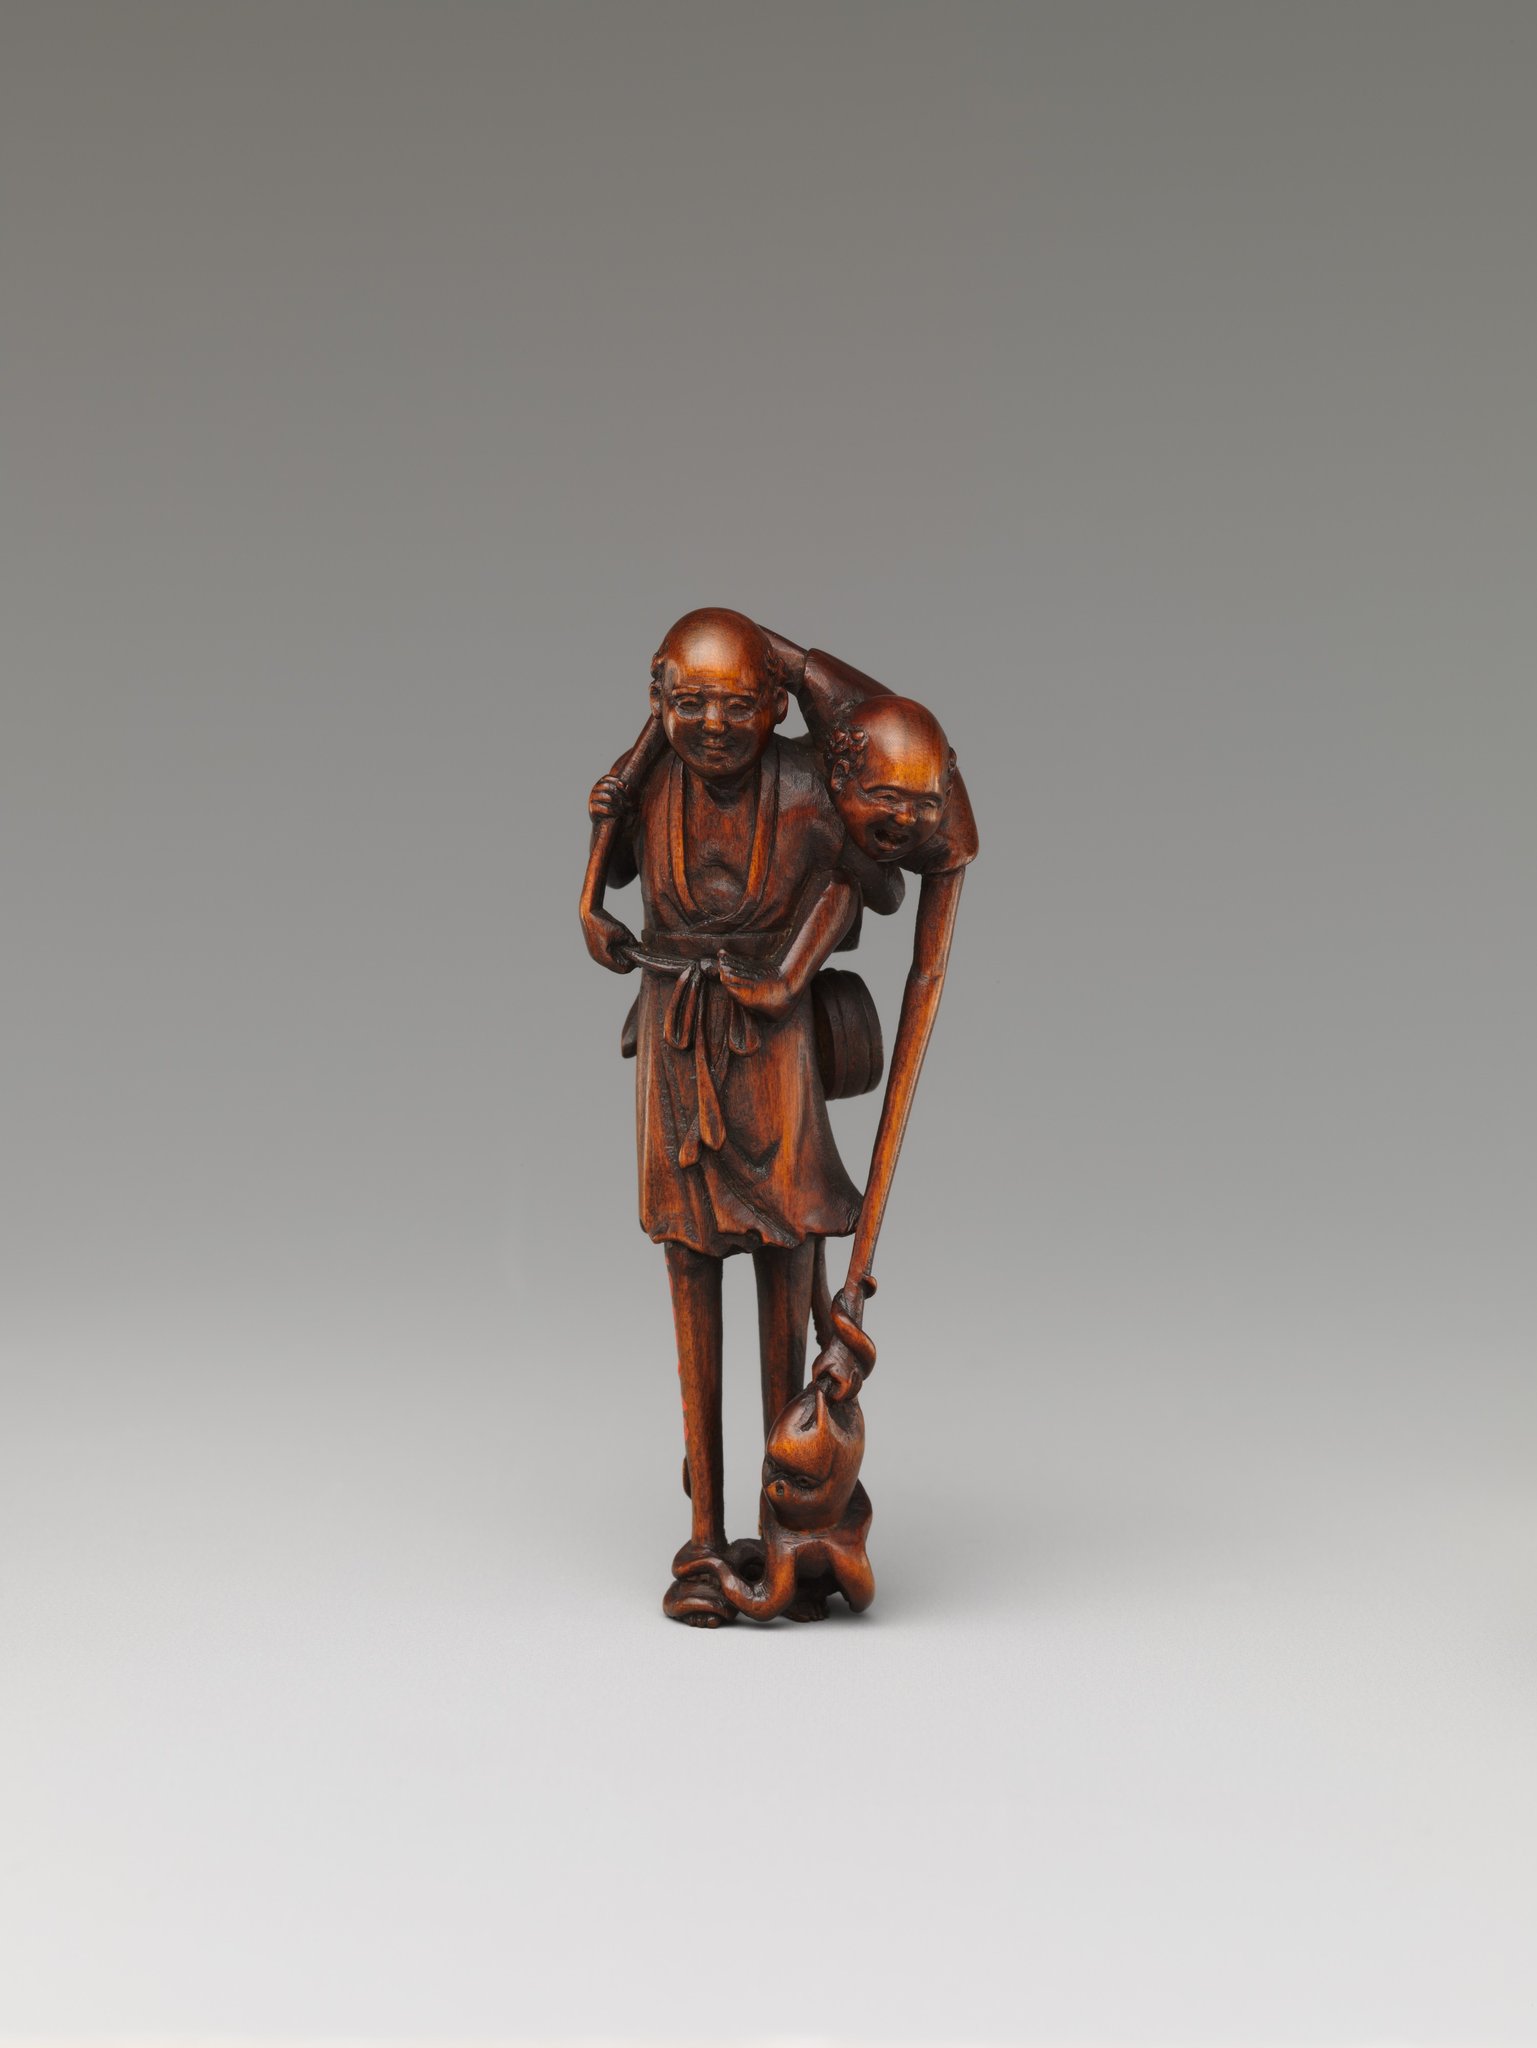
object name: netsuke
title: Netsuke of Ashinaga and Tenaga with an Octopus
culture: japanese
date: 1701-1800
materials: wood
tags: men,octopus